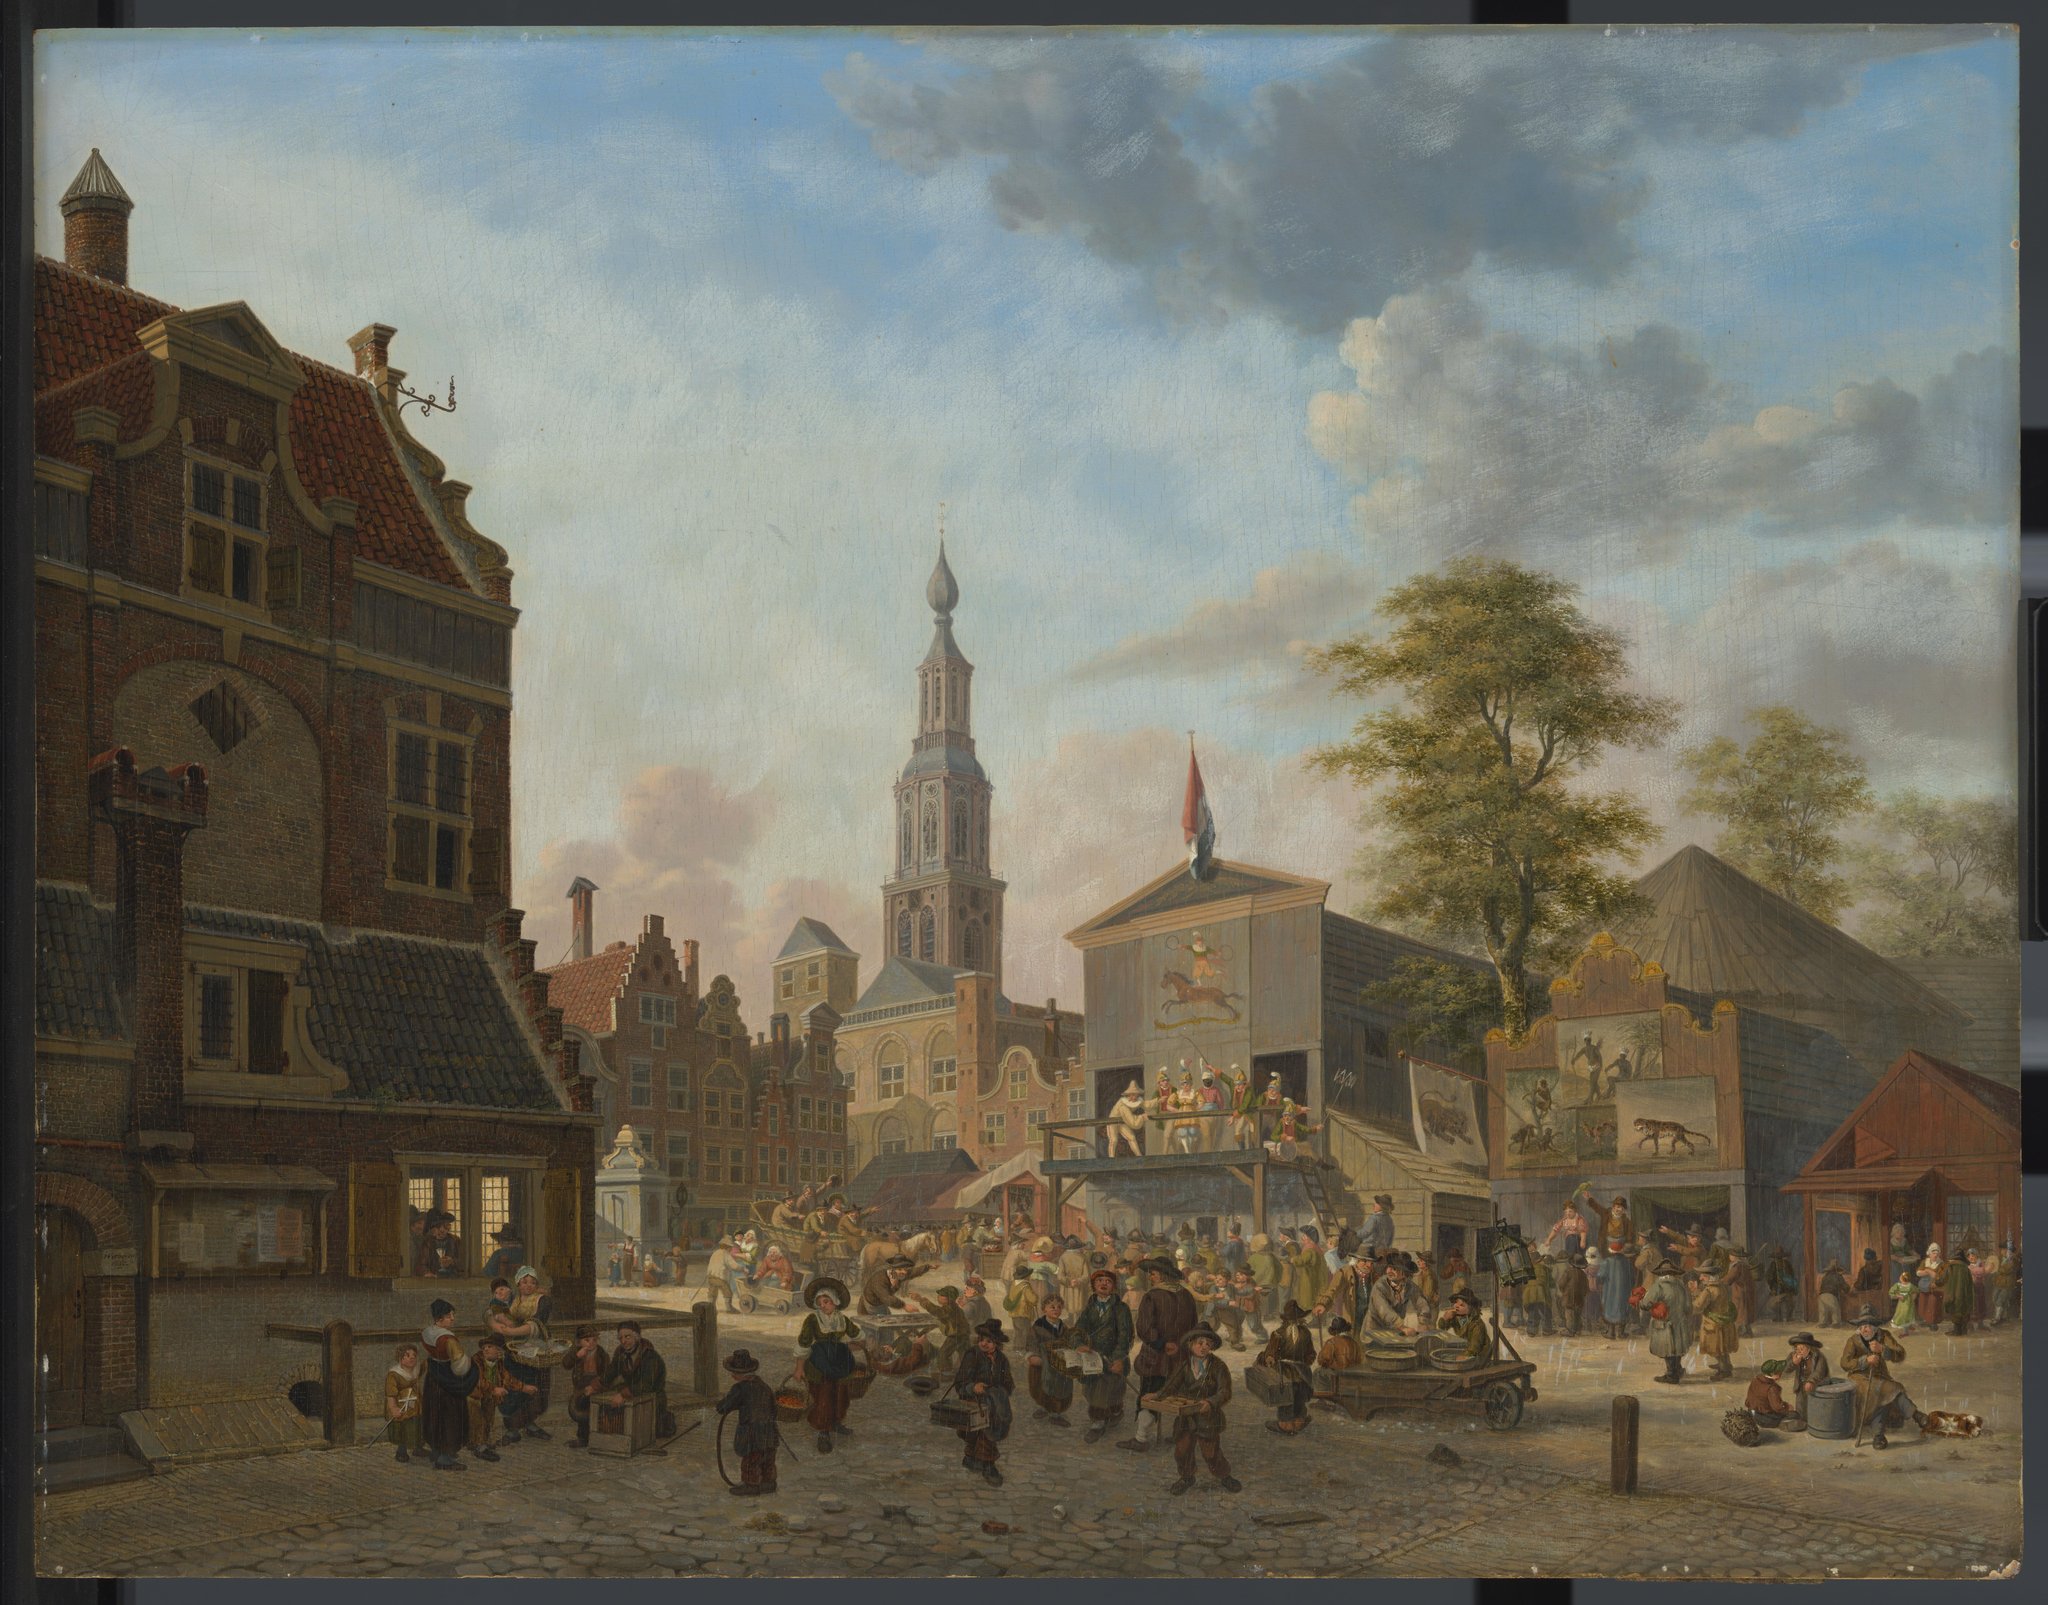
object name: painting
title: A town square with a fair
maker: jan hendrik verheijen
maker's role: draughtsman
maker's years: 1778-1846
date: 1820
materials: wood, paint, panel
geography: utrecht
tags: square, place, circus, etc., circus performance with trained animals (monkeys, elephants, bears, lions and tigers, horses, dogs, dolphins, seals, fleas), acrobat ~ circus, pleasure fair and circus, market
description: Een kermis of (jaar-)markt op een groot plein in grootstedelijke omgeving, met centraal een tweetal grote kramen/tijdelijke gebouwen waar het publiek ter lering en/of vermaak op het podium van de linker kraam een gezelschap 'exotisch' geklede personen wordt getoond, waaronder centraal een vrouw, op de achtergrond een zwarte man of black face, een harlekijnachtig personage en een viertal uniform bont geklede personen. Tegen de voorgevel van de kraam een plakkaat/rolschildering met een paard waarop een staande/balancerende vrouw en op de rechter kraam rolschilderingen die tonen wat binnen is te zien: een panter/tijger, een groep apen in een boom, andere dieren en een groep Zuid-Amerikaanse personages, mogelijk marrons. De geografische setting kan niet worden geduid en is vrij zeker een gefantaseerde setting waar wel bestaande gebouwen, waaronder het stadskasteel aan de Neude te Utrecht, is te zien.